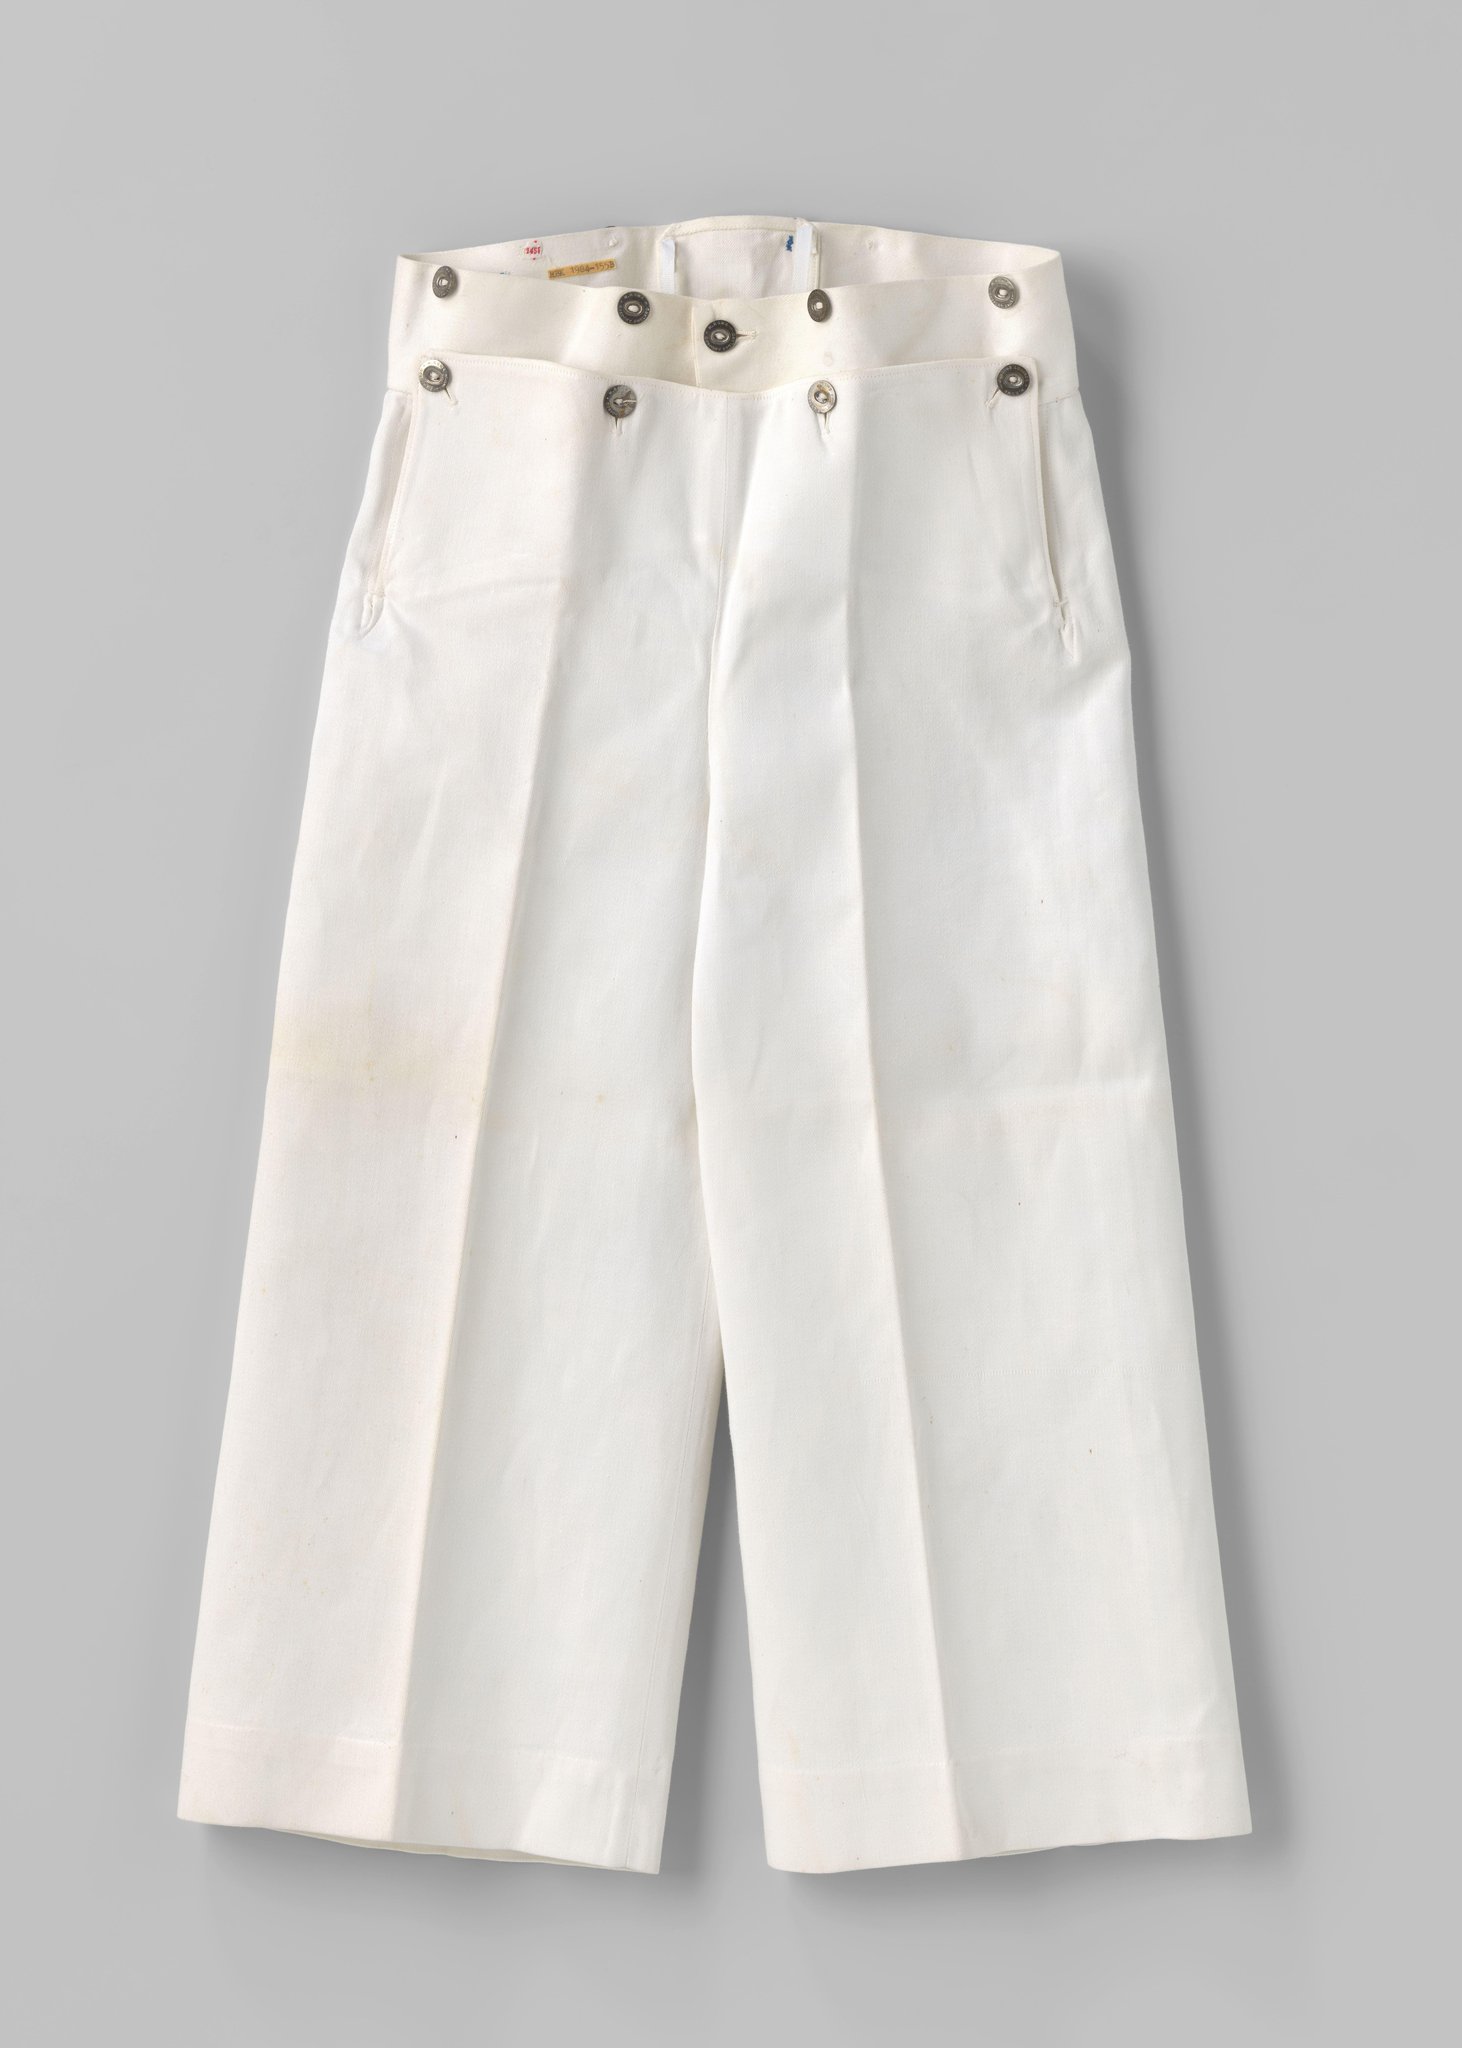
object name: matrozenbroek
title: Lange wijde matrozenbroek, met metalen knopen, van wit linnen, afgezet met blauwe banden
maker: william rowe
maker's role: designer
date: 1930-1940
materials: linen, metal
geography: gosport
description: Adres knopen: W. Rowe, Gospact, England.